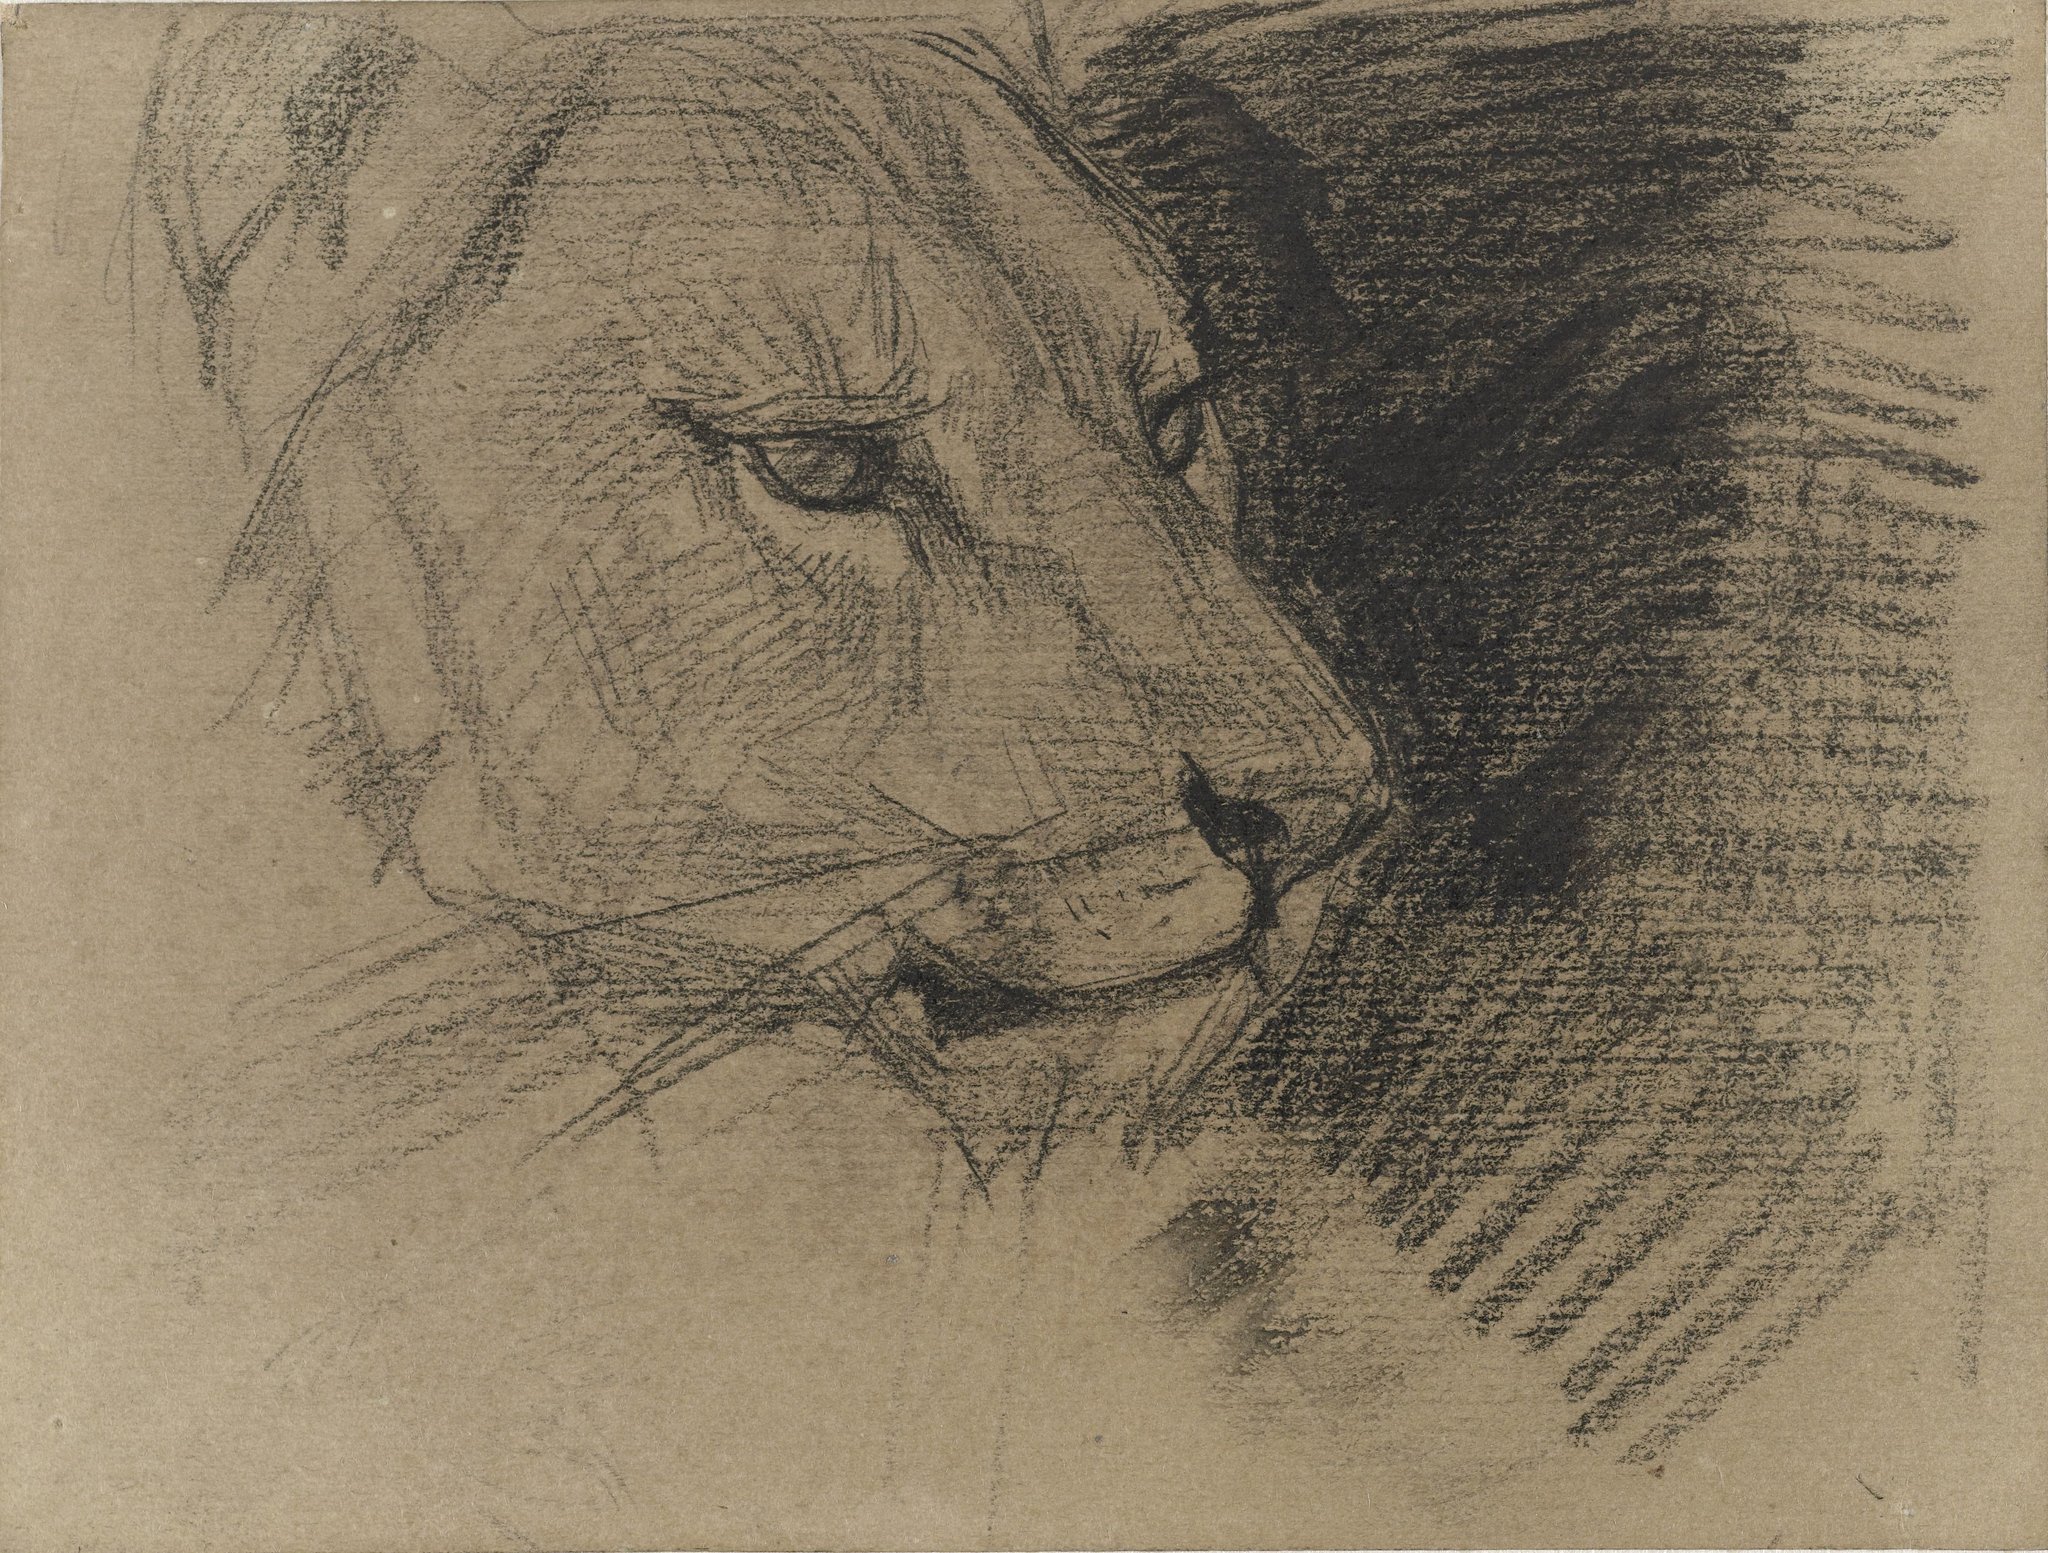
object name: drawing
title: Kop van een leeuw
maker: august allebé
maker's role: draughtsman, print maker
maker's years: 1838-1927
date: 1848-1884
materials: chalk, paper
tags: beasts of prey, predatory animals: lion